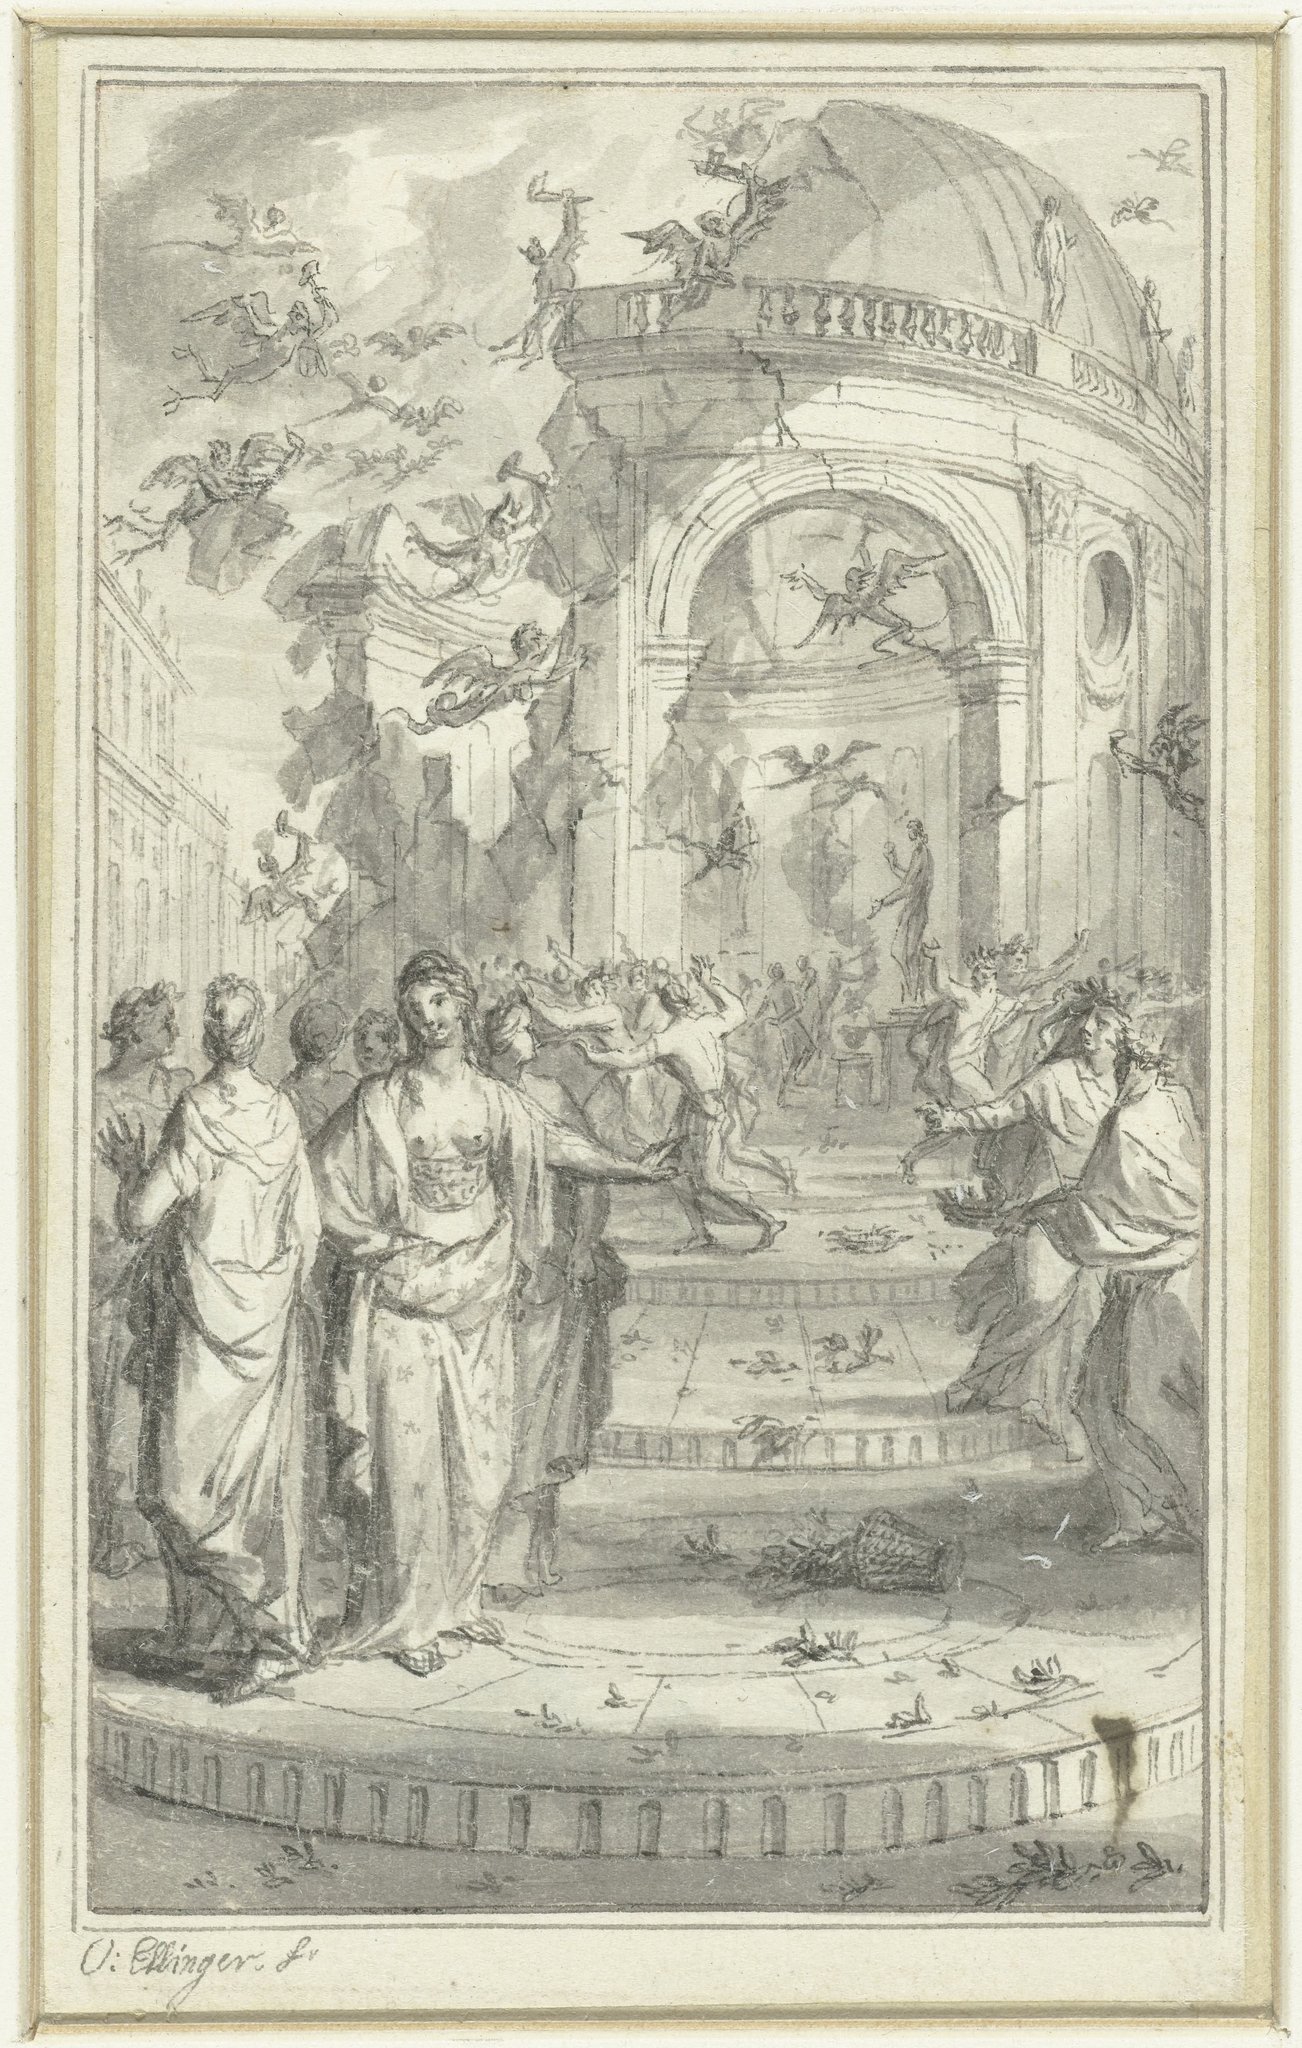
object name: drawing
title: Vernietiging van een tempel door duivels en harpijen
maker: ottmar elliger (ii)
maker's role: draughtsman, print maker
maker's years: 1666-1735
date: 1676-1735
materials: chalk, ink, paper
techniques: brush, pen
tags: devils in the form of (fabulous) animals, devil(s) and demons, demolition of building, temple, shrine ~ non-christian religions, harpy (fabulous bird); 'arpie' (ripa)